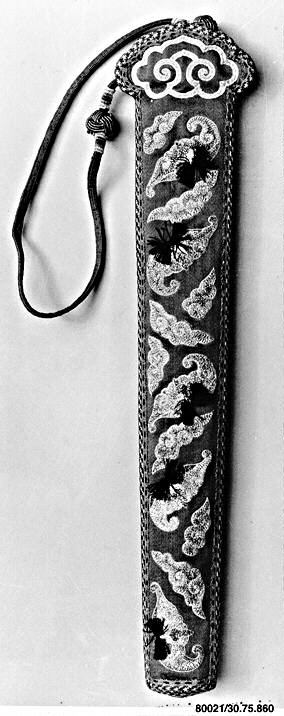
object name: fan holder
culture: chinese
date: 1701-1900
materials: metal thread, silk